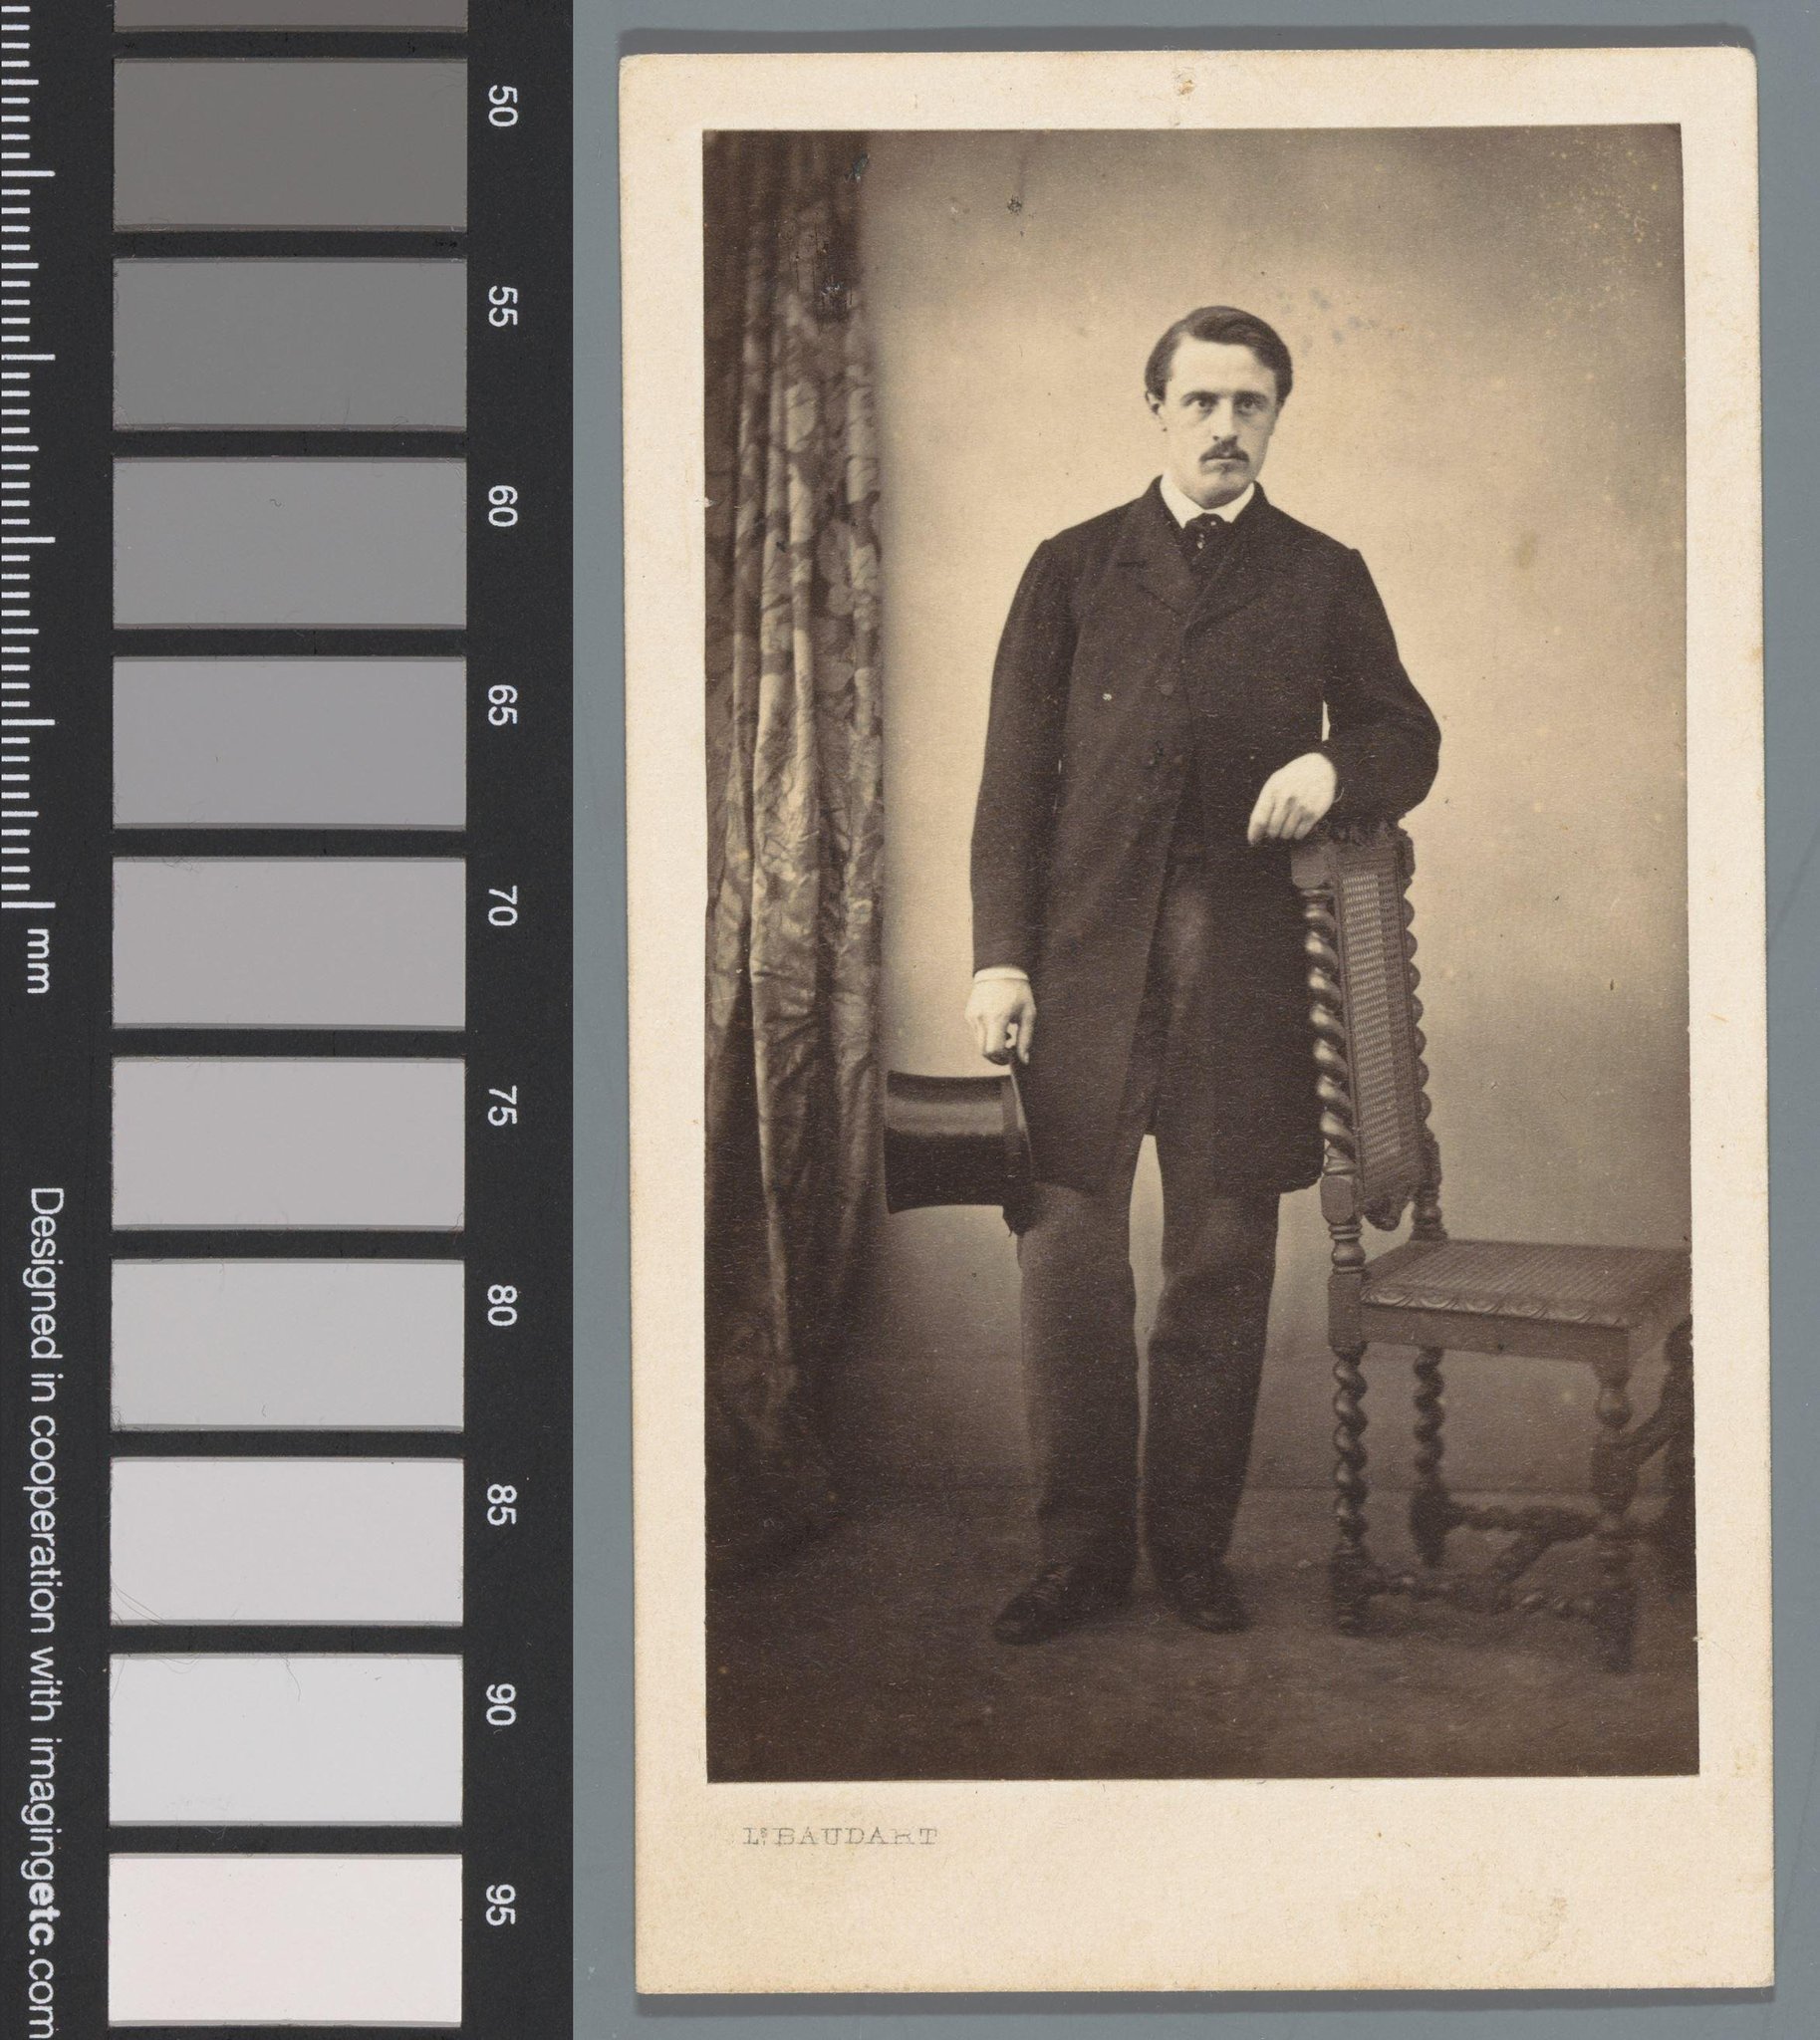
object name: carte de visite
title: Portret van een onbekende man met hoge hoed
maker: louis baudart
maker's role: fotograaf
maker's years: 1828-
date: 1865-1876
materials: cardboard, paper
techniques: albumen print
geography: reims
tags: adult man, anonymous historical person portrayed, head-gear: top hat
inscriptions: inscription: ‘Ls. Baudart’, inscription: ‘Ls. Baudart/ Peintre & photographe/ 80, Rue du Bourg St. Denis, 80/ Reims.’